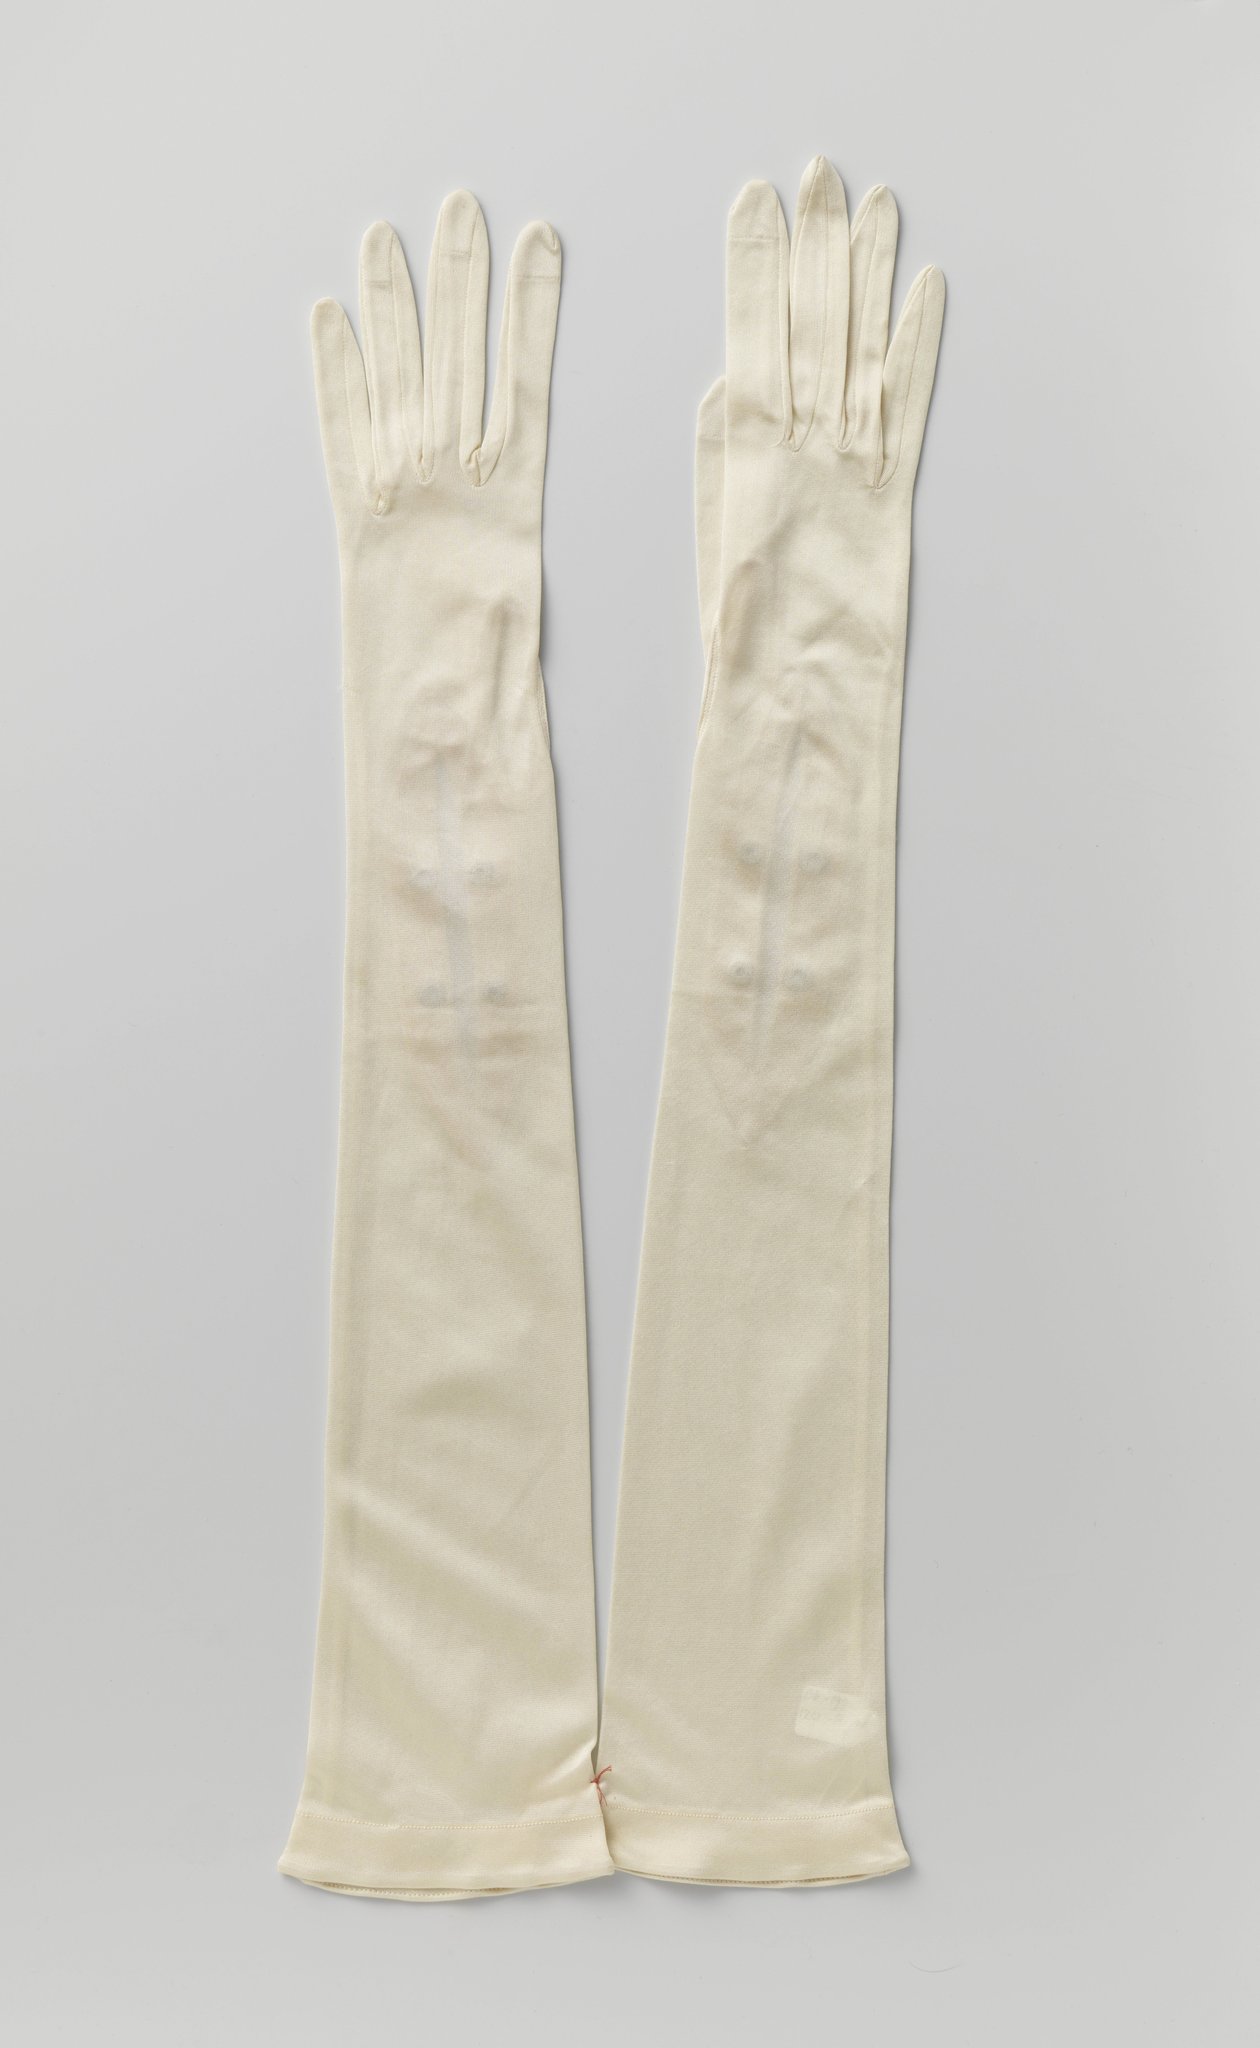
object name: glove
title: Handschoenen in wit zijden tricot, met drukknoopsluiting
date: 1925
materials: silk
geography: germany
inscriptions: mark: ‘mayfair’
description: Linkerhandschoen in wit zijden tricot, met drukknoopsluiting.